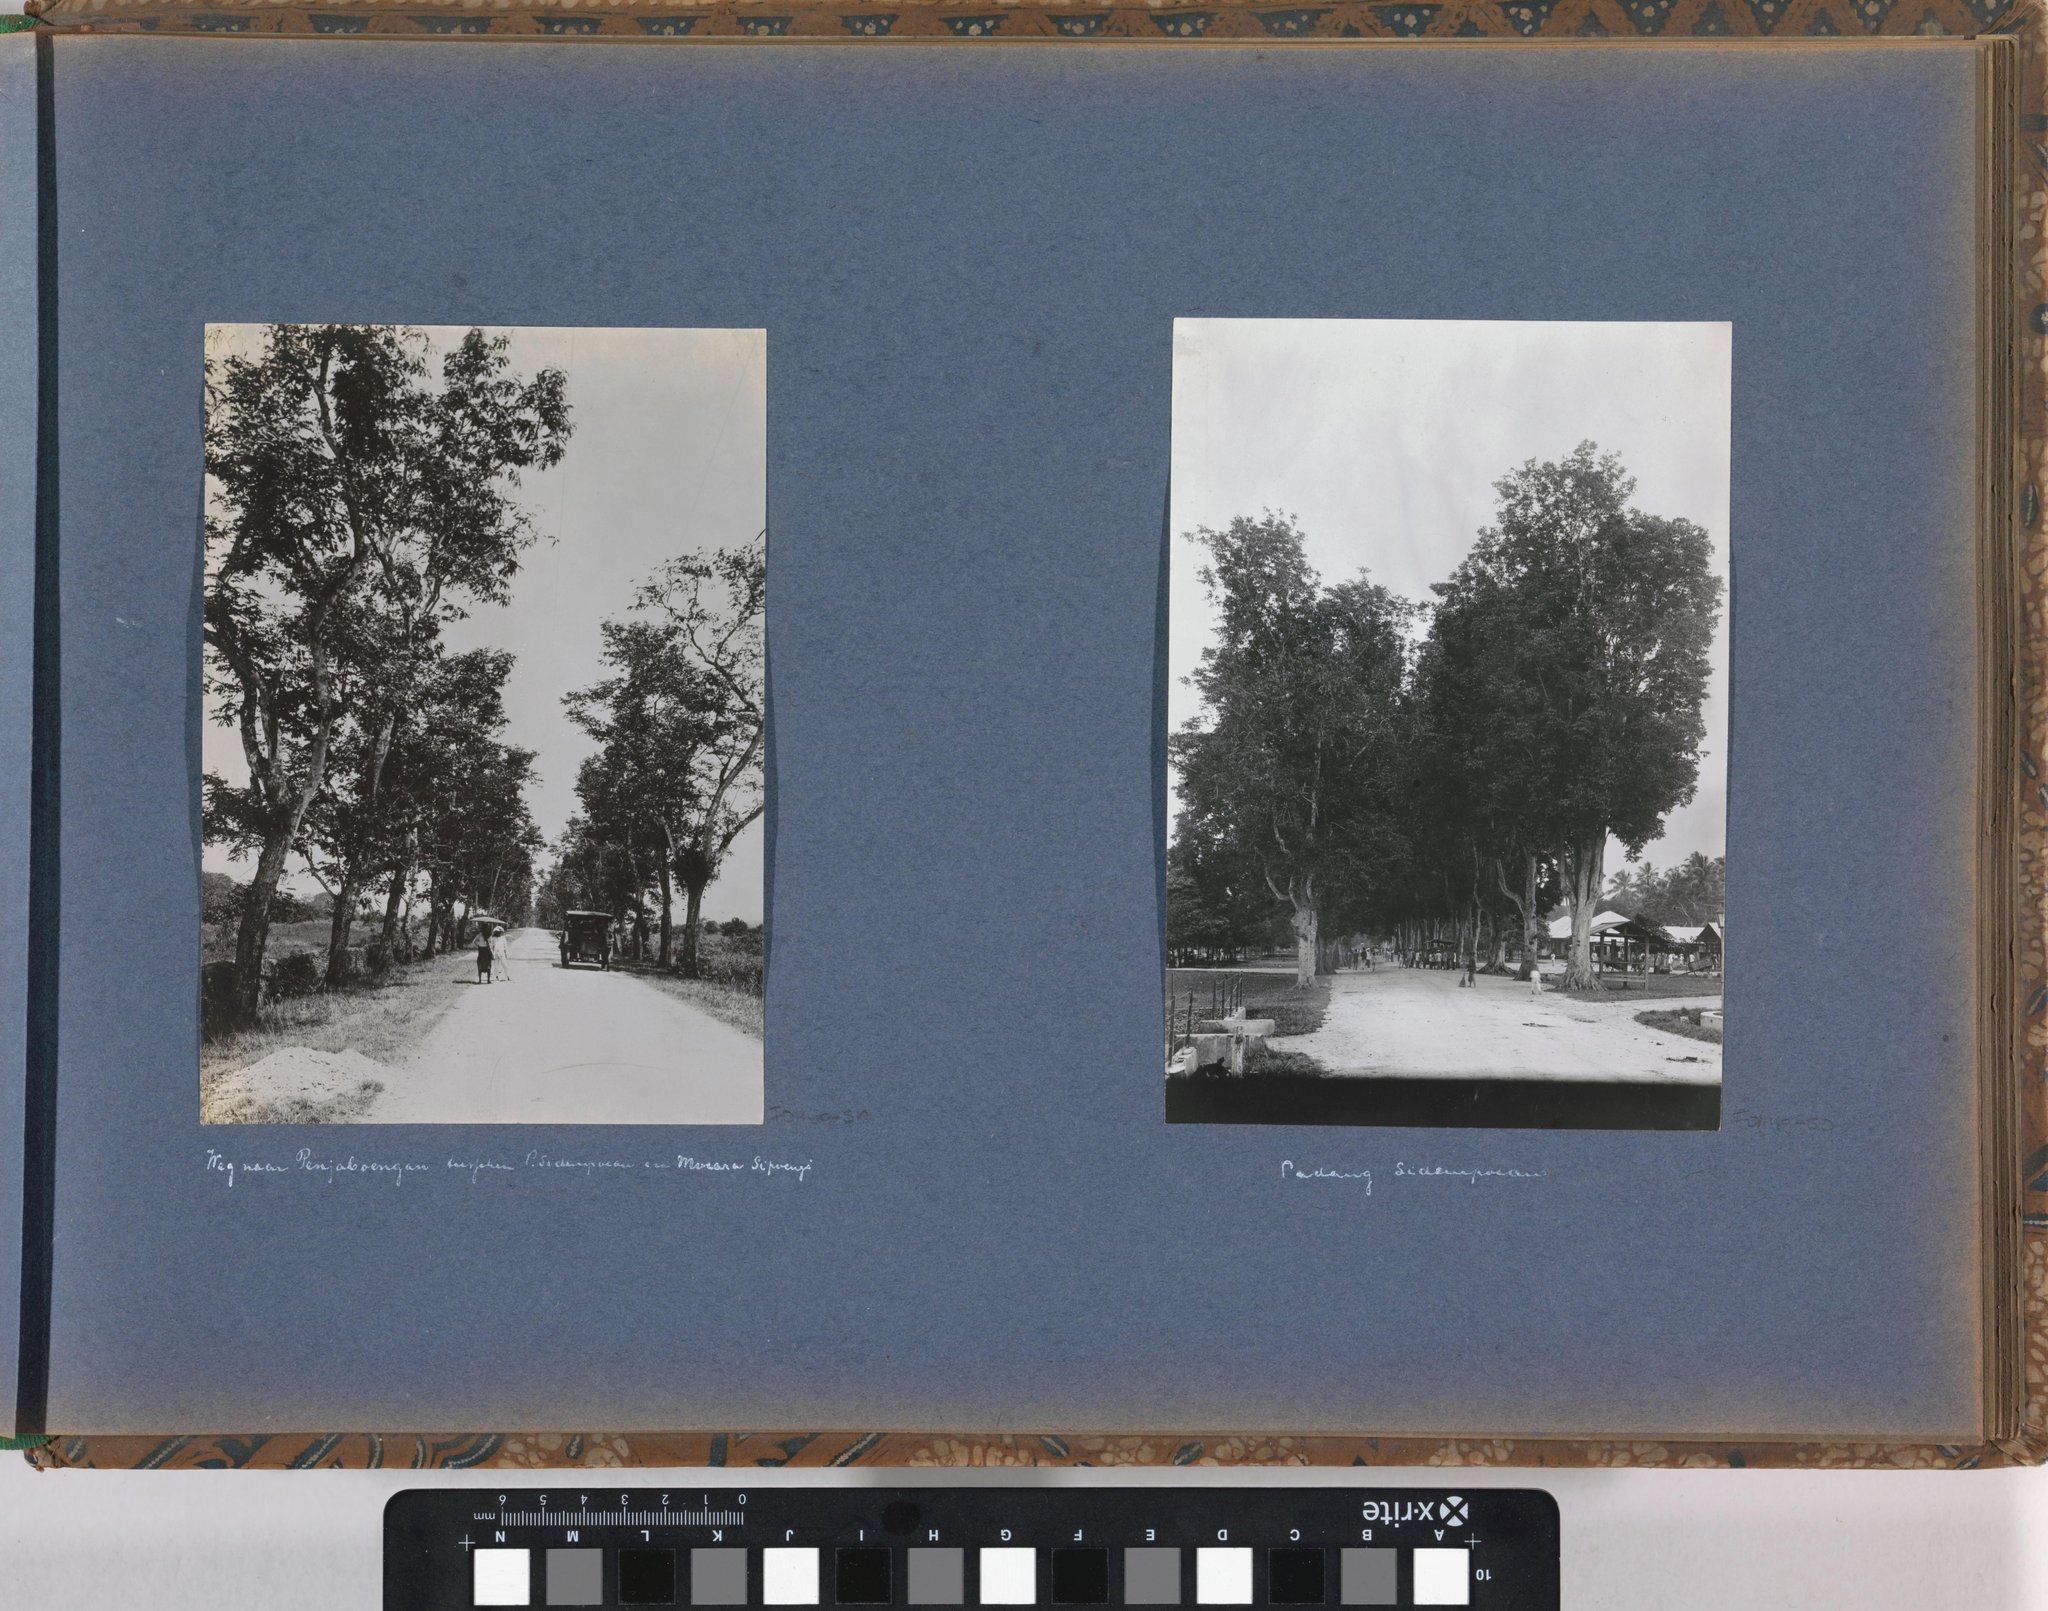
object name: photograph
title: Auto en twee mensen onder een parasol op de weg naar Penjaboengan op Sumatra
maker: Anonymous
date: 1900-1920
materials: paper, photographic support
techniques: gelatin silver print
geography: sumatra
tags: road, path, automobile, sumatra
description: Onderdeel van reisalbum met foto's van bedrijvigheid en bezienswaardigheden op Sumatra en Java en van de reis naar en van Nederlands-Indië.